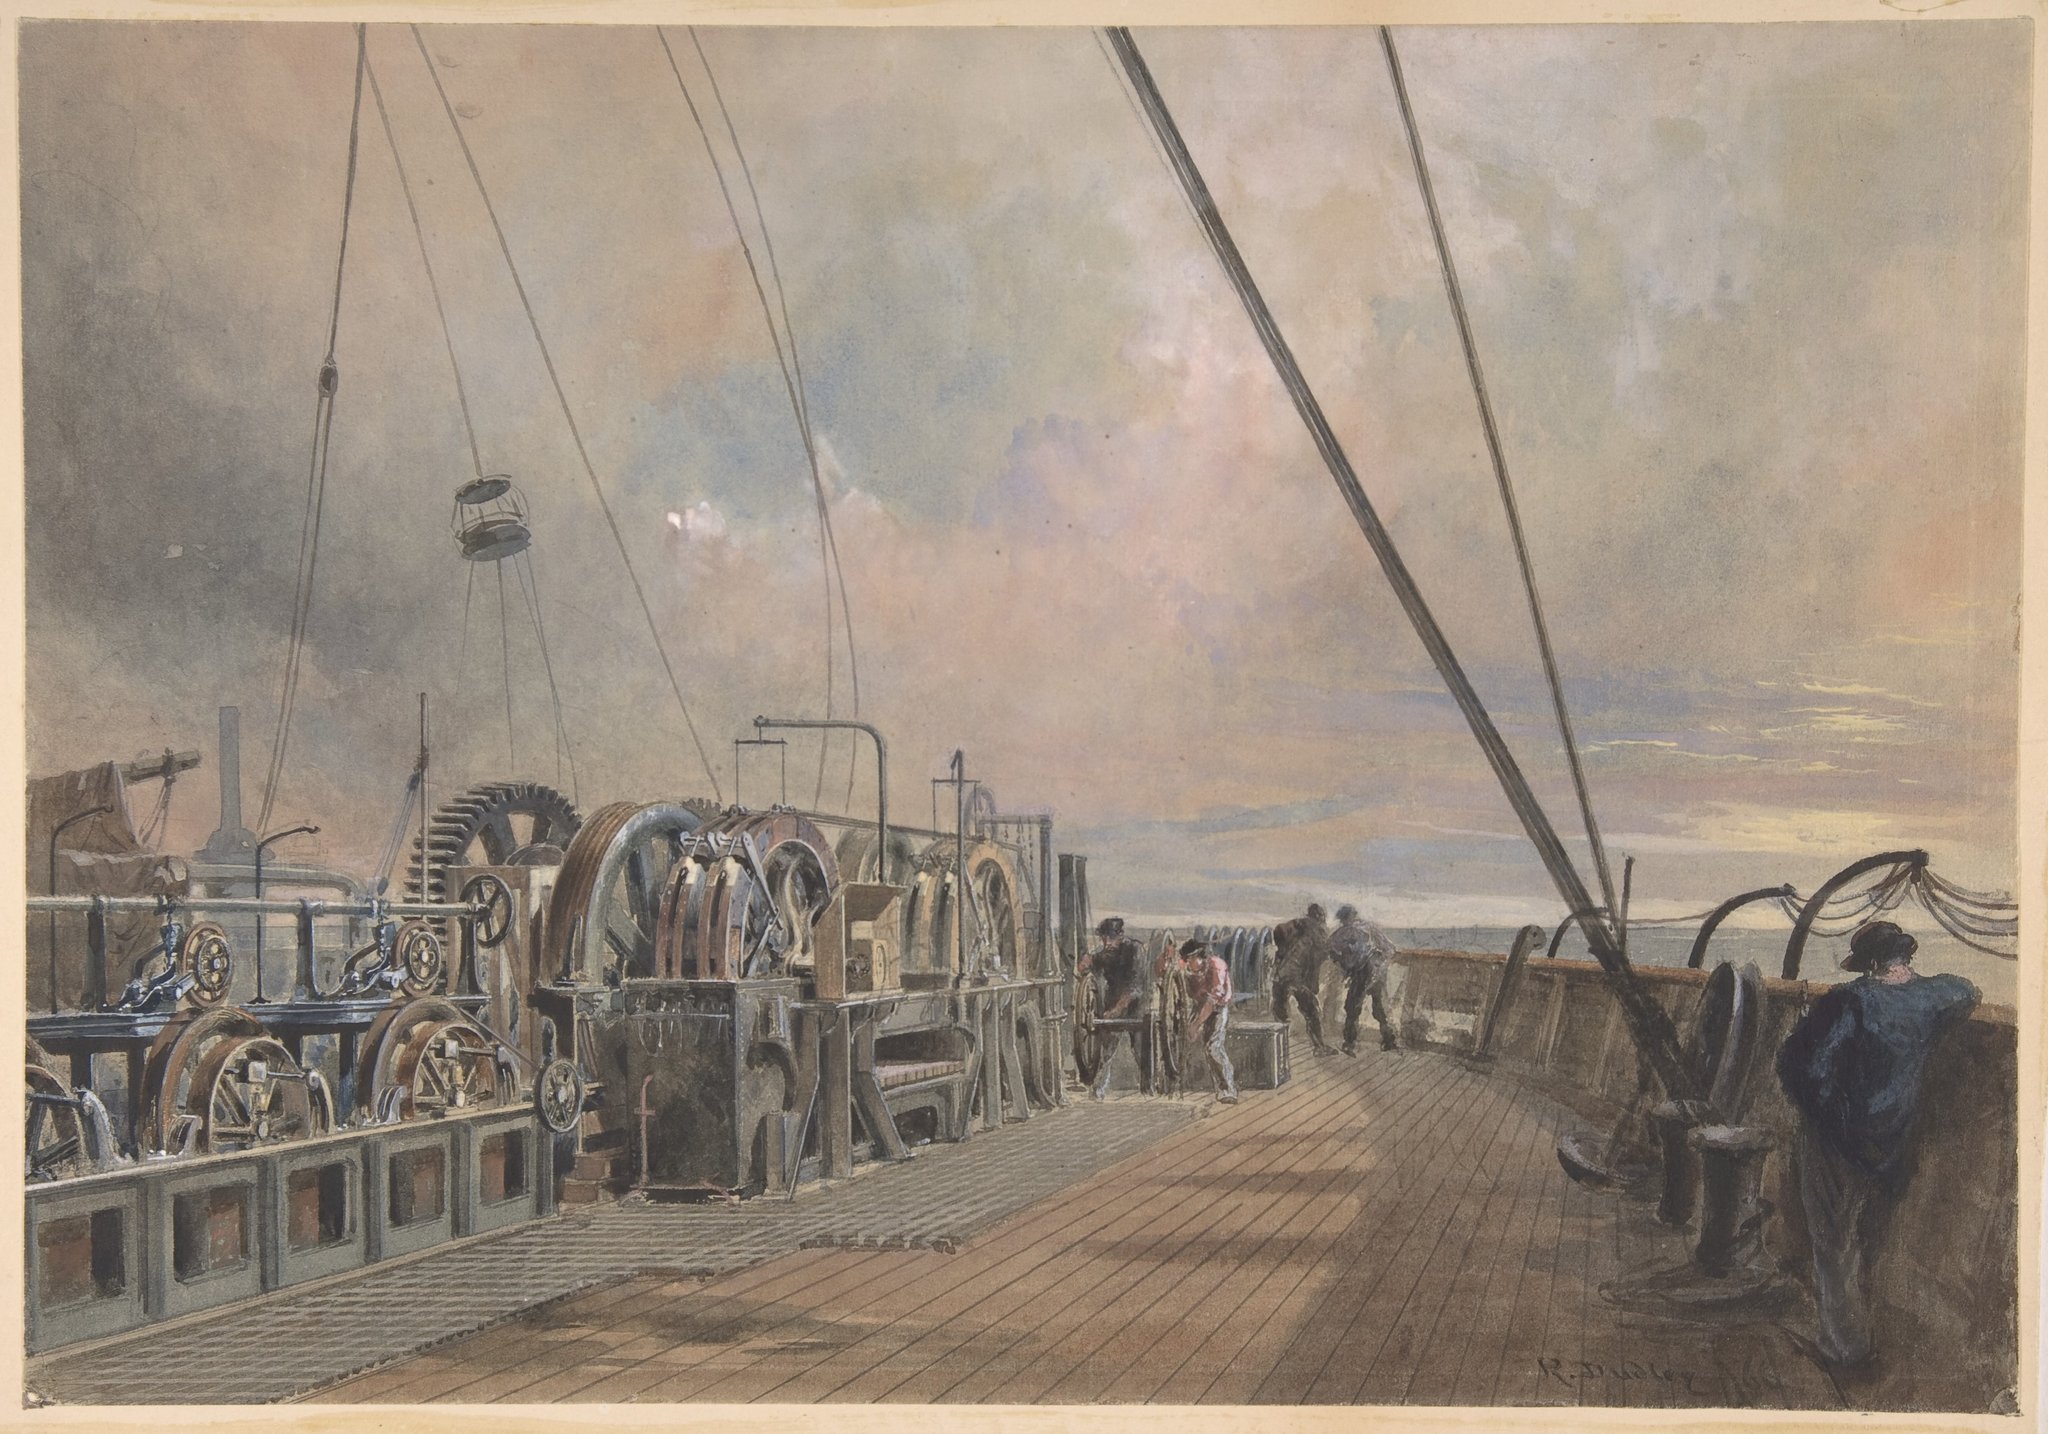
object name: drawing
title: Deck of Great Eastern, Aft: the Paying-out Machinery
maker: robert charles dudley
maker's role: artist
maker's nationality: british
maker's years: 1826-1909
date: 1866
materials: gouache, graphite, watercolor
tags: men,ships,transatlantic cable